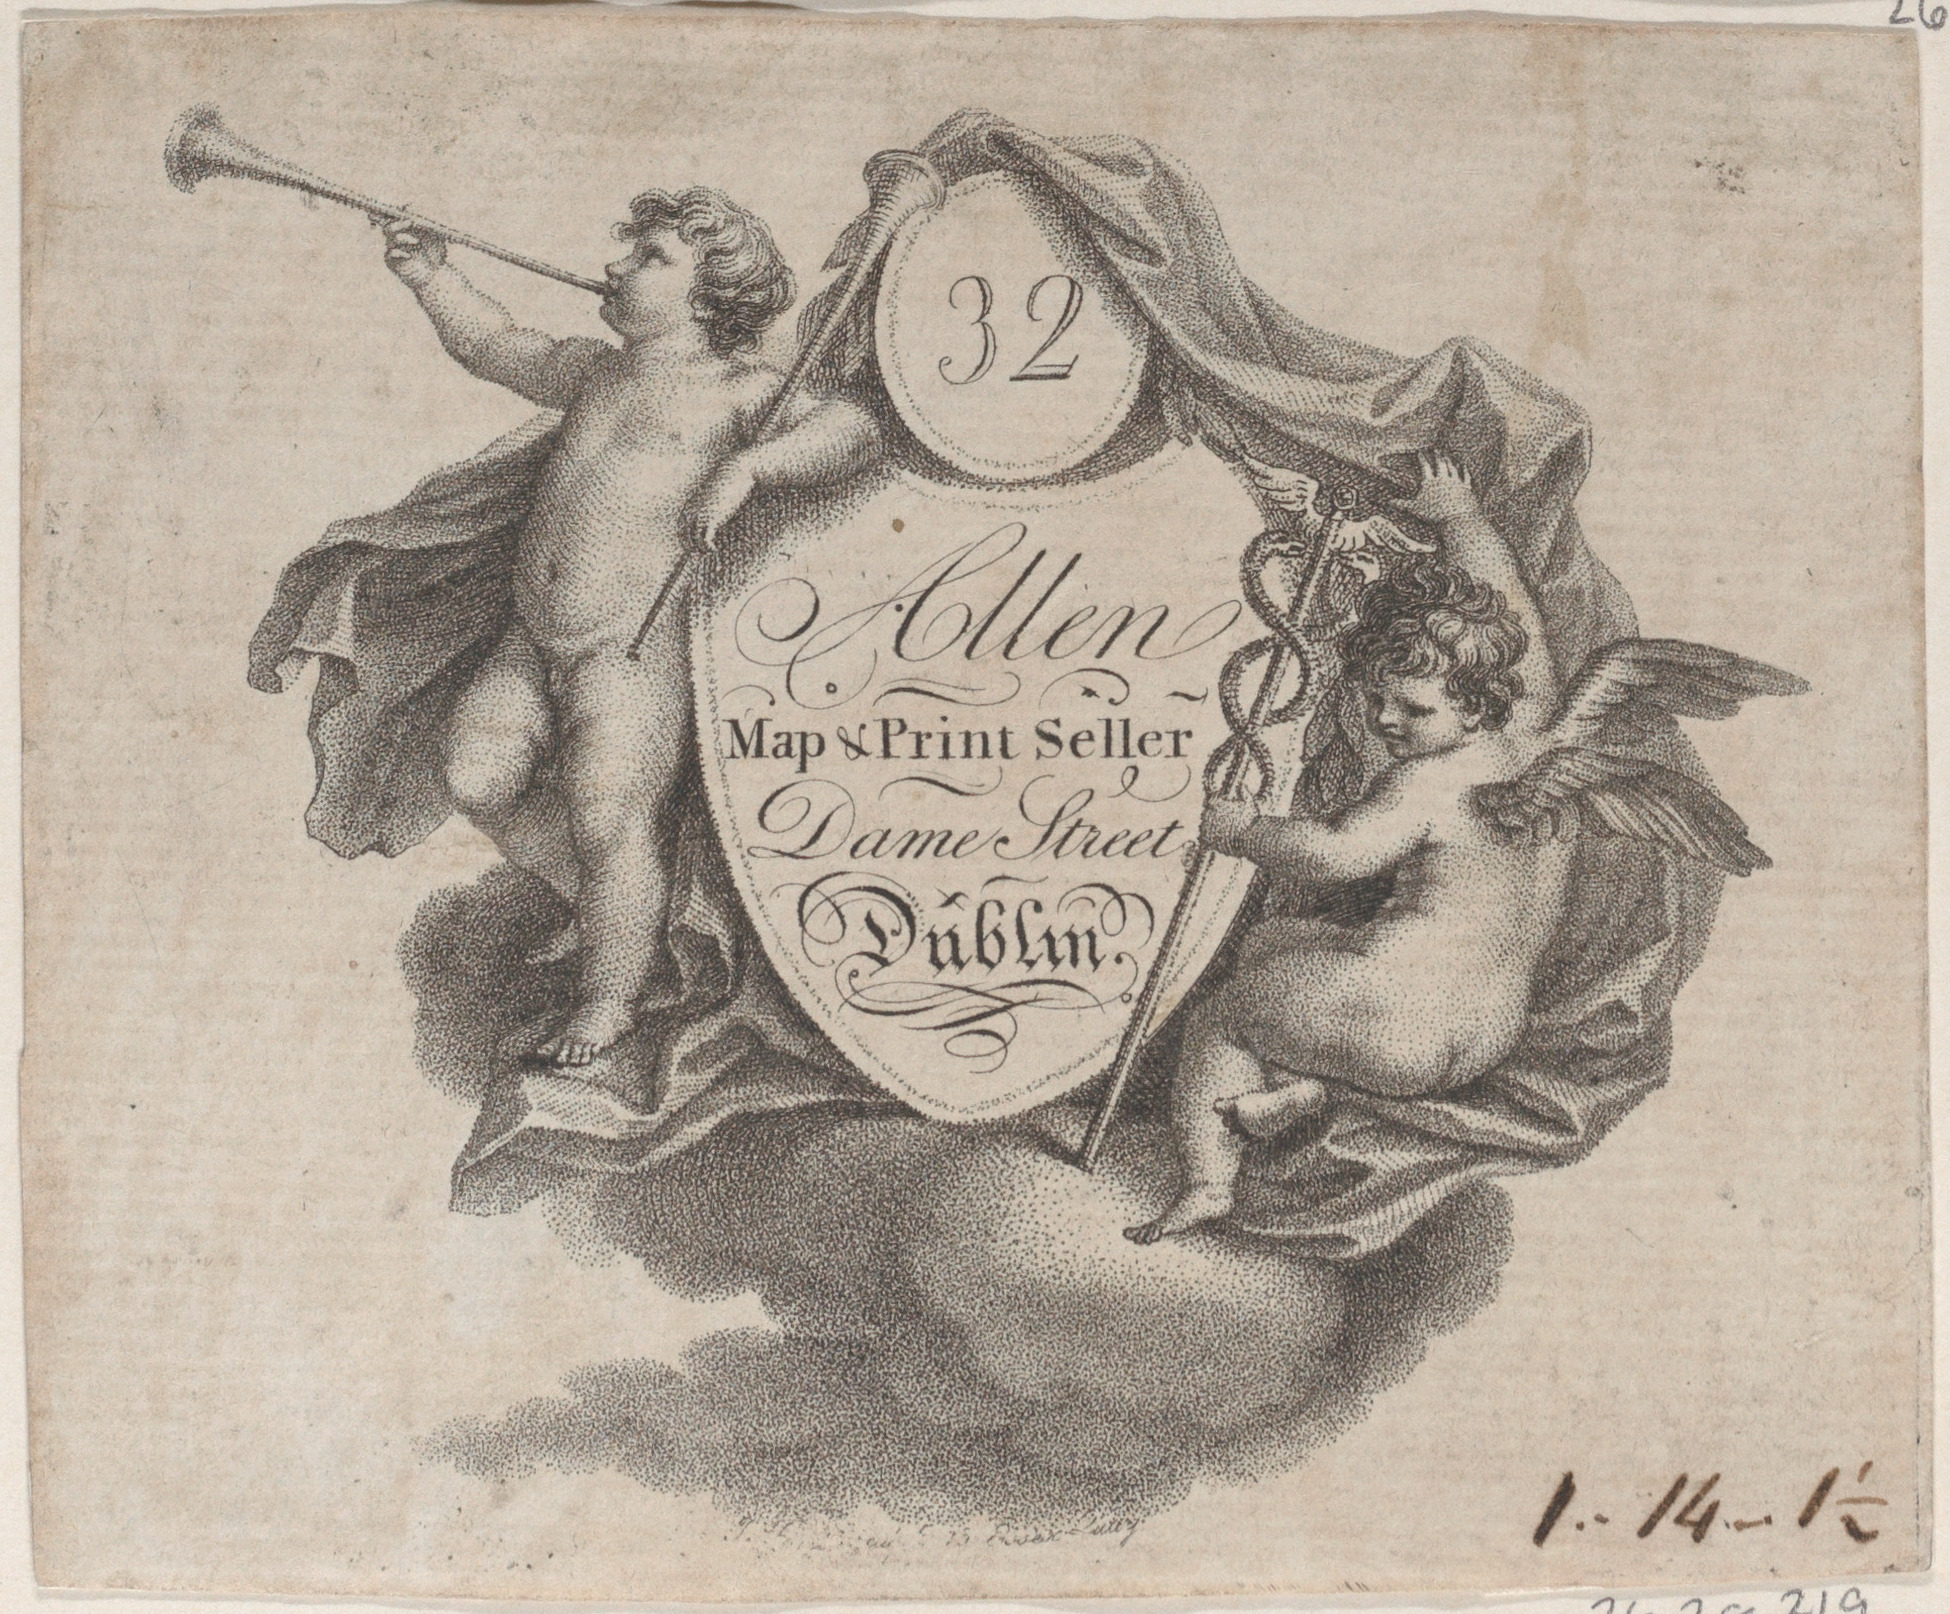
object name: print, trade card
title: Trade card for William Allen, Map and Print Seller in Dublin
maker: anonymous, british, late 18th–early 19th century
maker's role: artist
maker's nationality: british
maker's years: 1771-1835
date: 1767-1833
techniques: etching